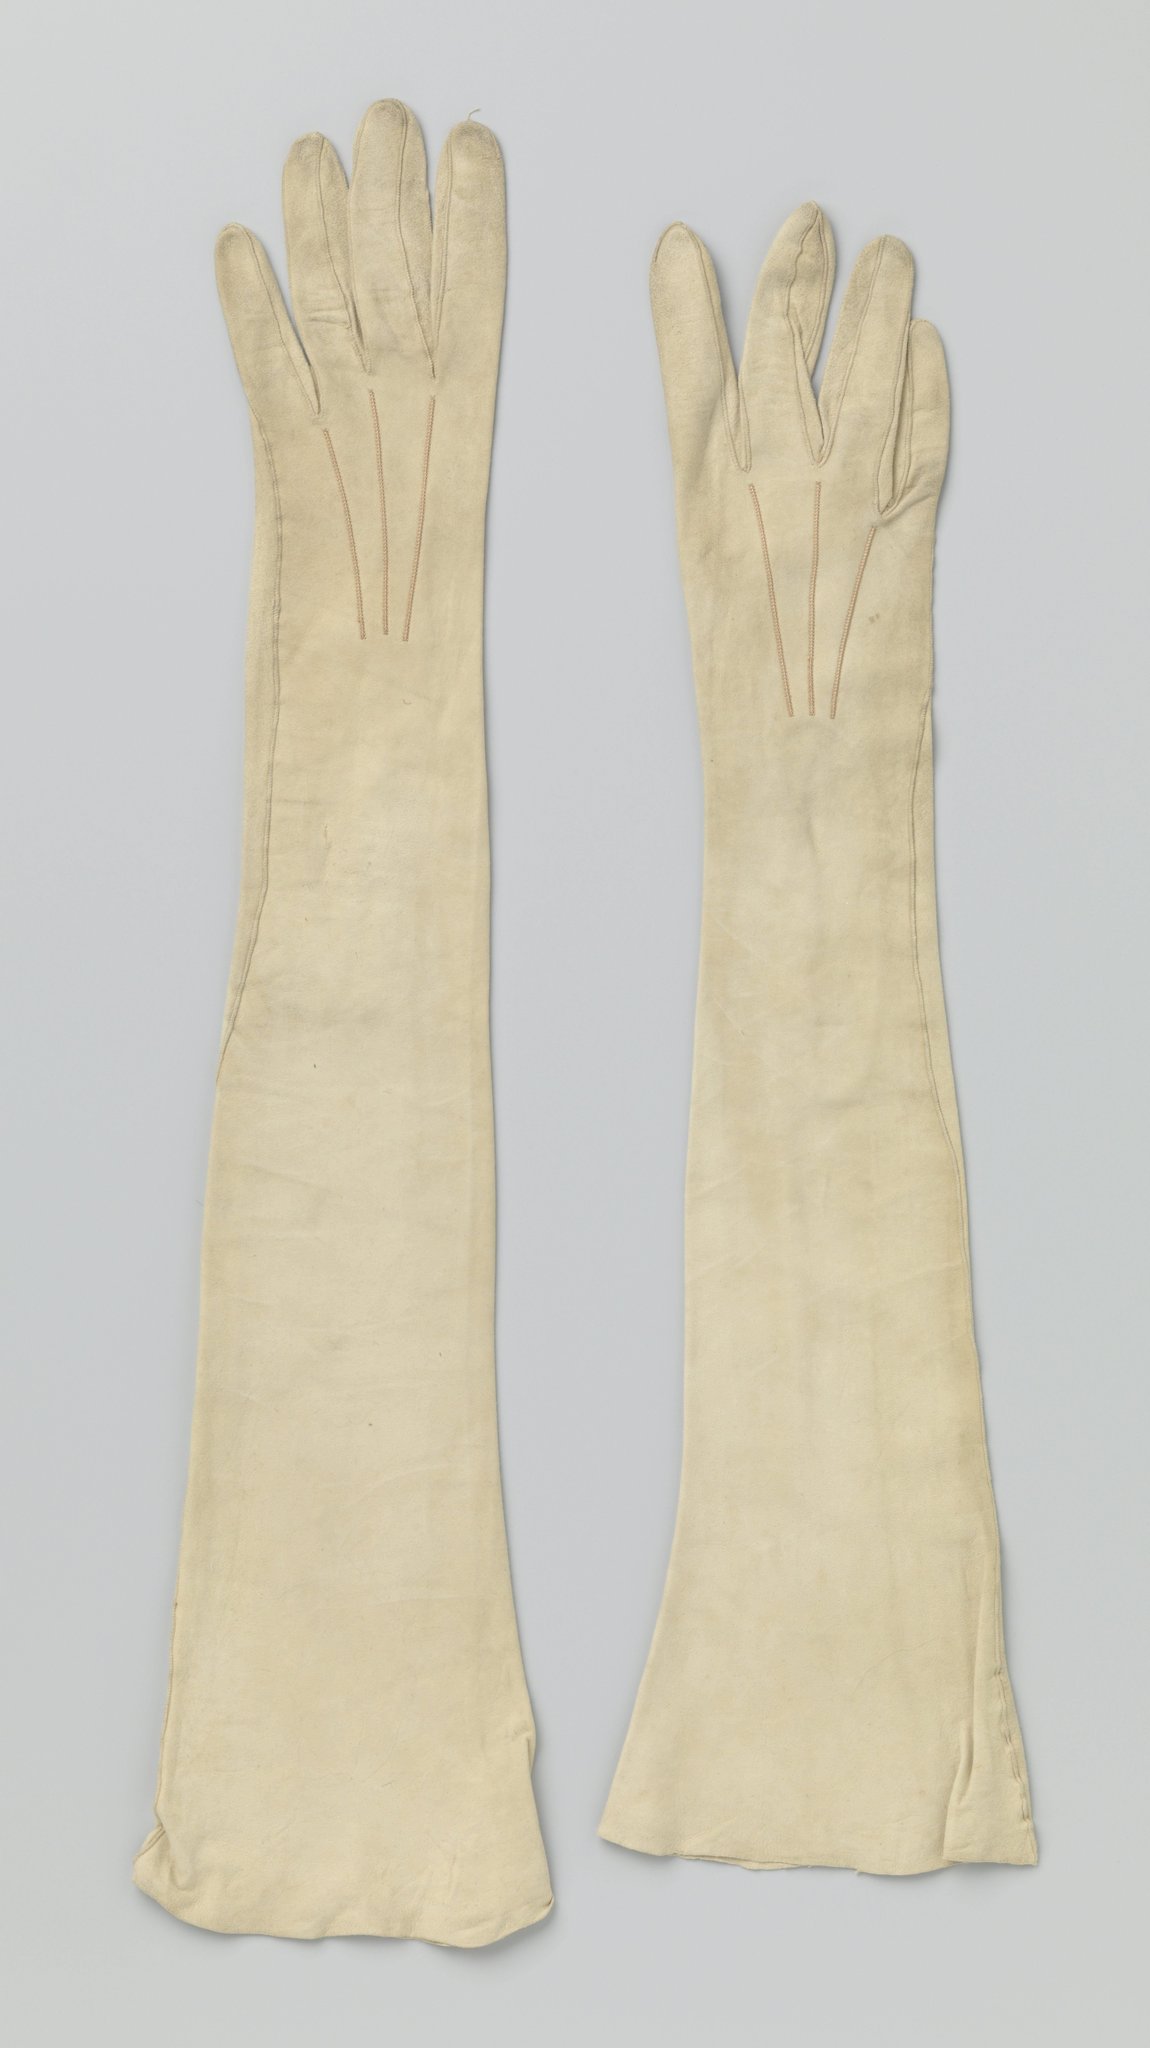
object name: clothing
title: Handschoen van beige zeemleer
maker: sozette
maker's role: handschoenenmaker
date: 1900-1920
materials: leather, mother of pearl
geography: france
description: Linkerhandschoen van beige zeemleer met op de rug drie geborduurde goudkleurige lijnen. Split met drie platte knopen. Maat 6 1/2, merk: SOZETTE, FABRIQUE PAR....